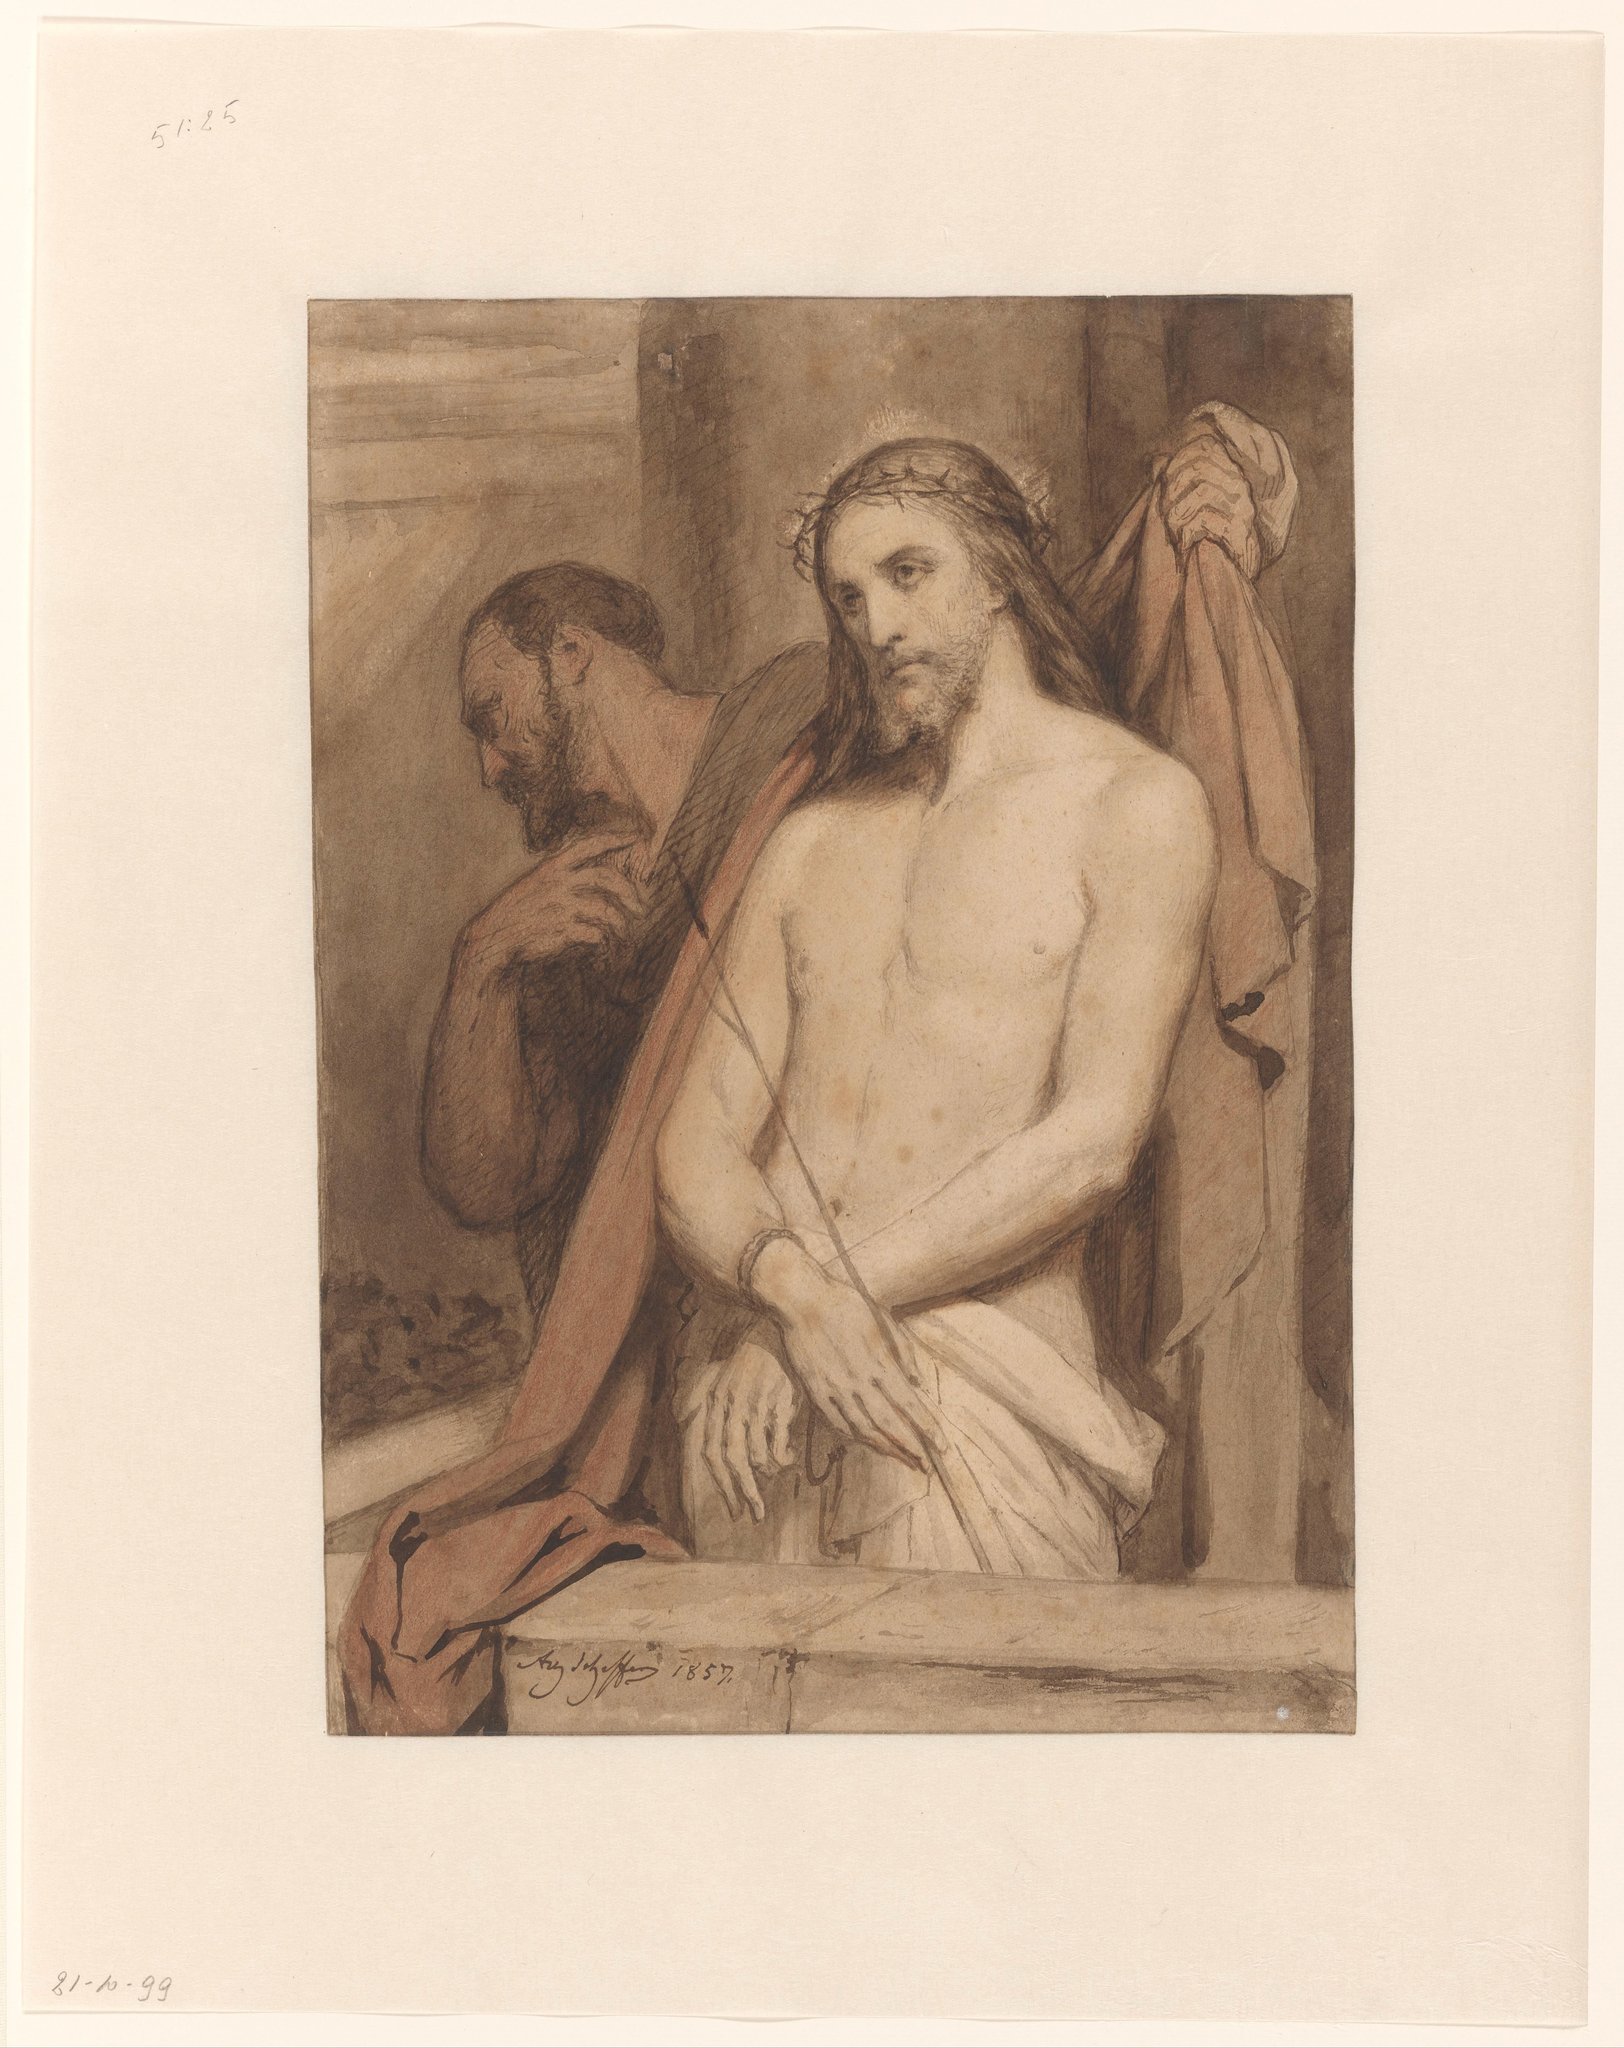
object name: drawing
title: Ecce Homo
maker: ary scheffer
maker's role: draughtsman, painter, print maker, sculptor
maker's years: 1795-1858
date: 1857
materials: chalk, ink, paper, pencil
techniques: brush, pen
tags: pilate showing christ to the people, 'ostentatio christi', 'ecce homo' (john 19:4-6)